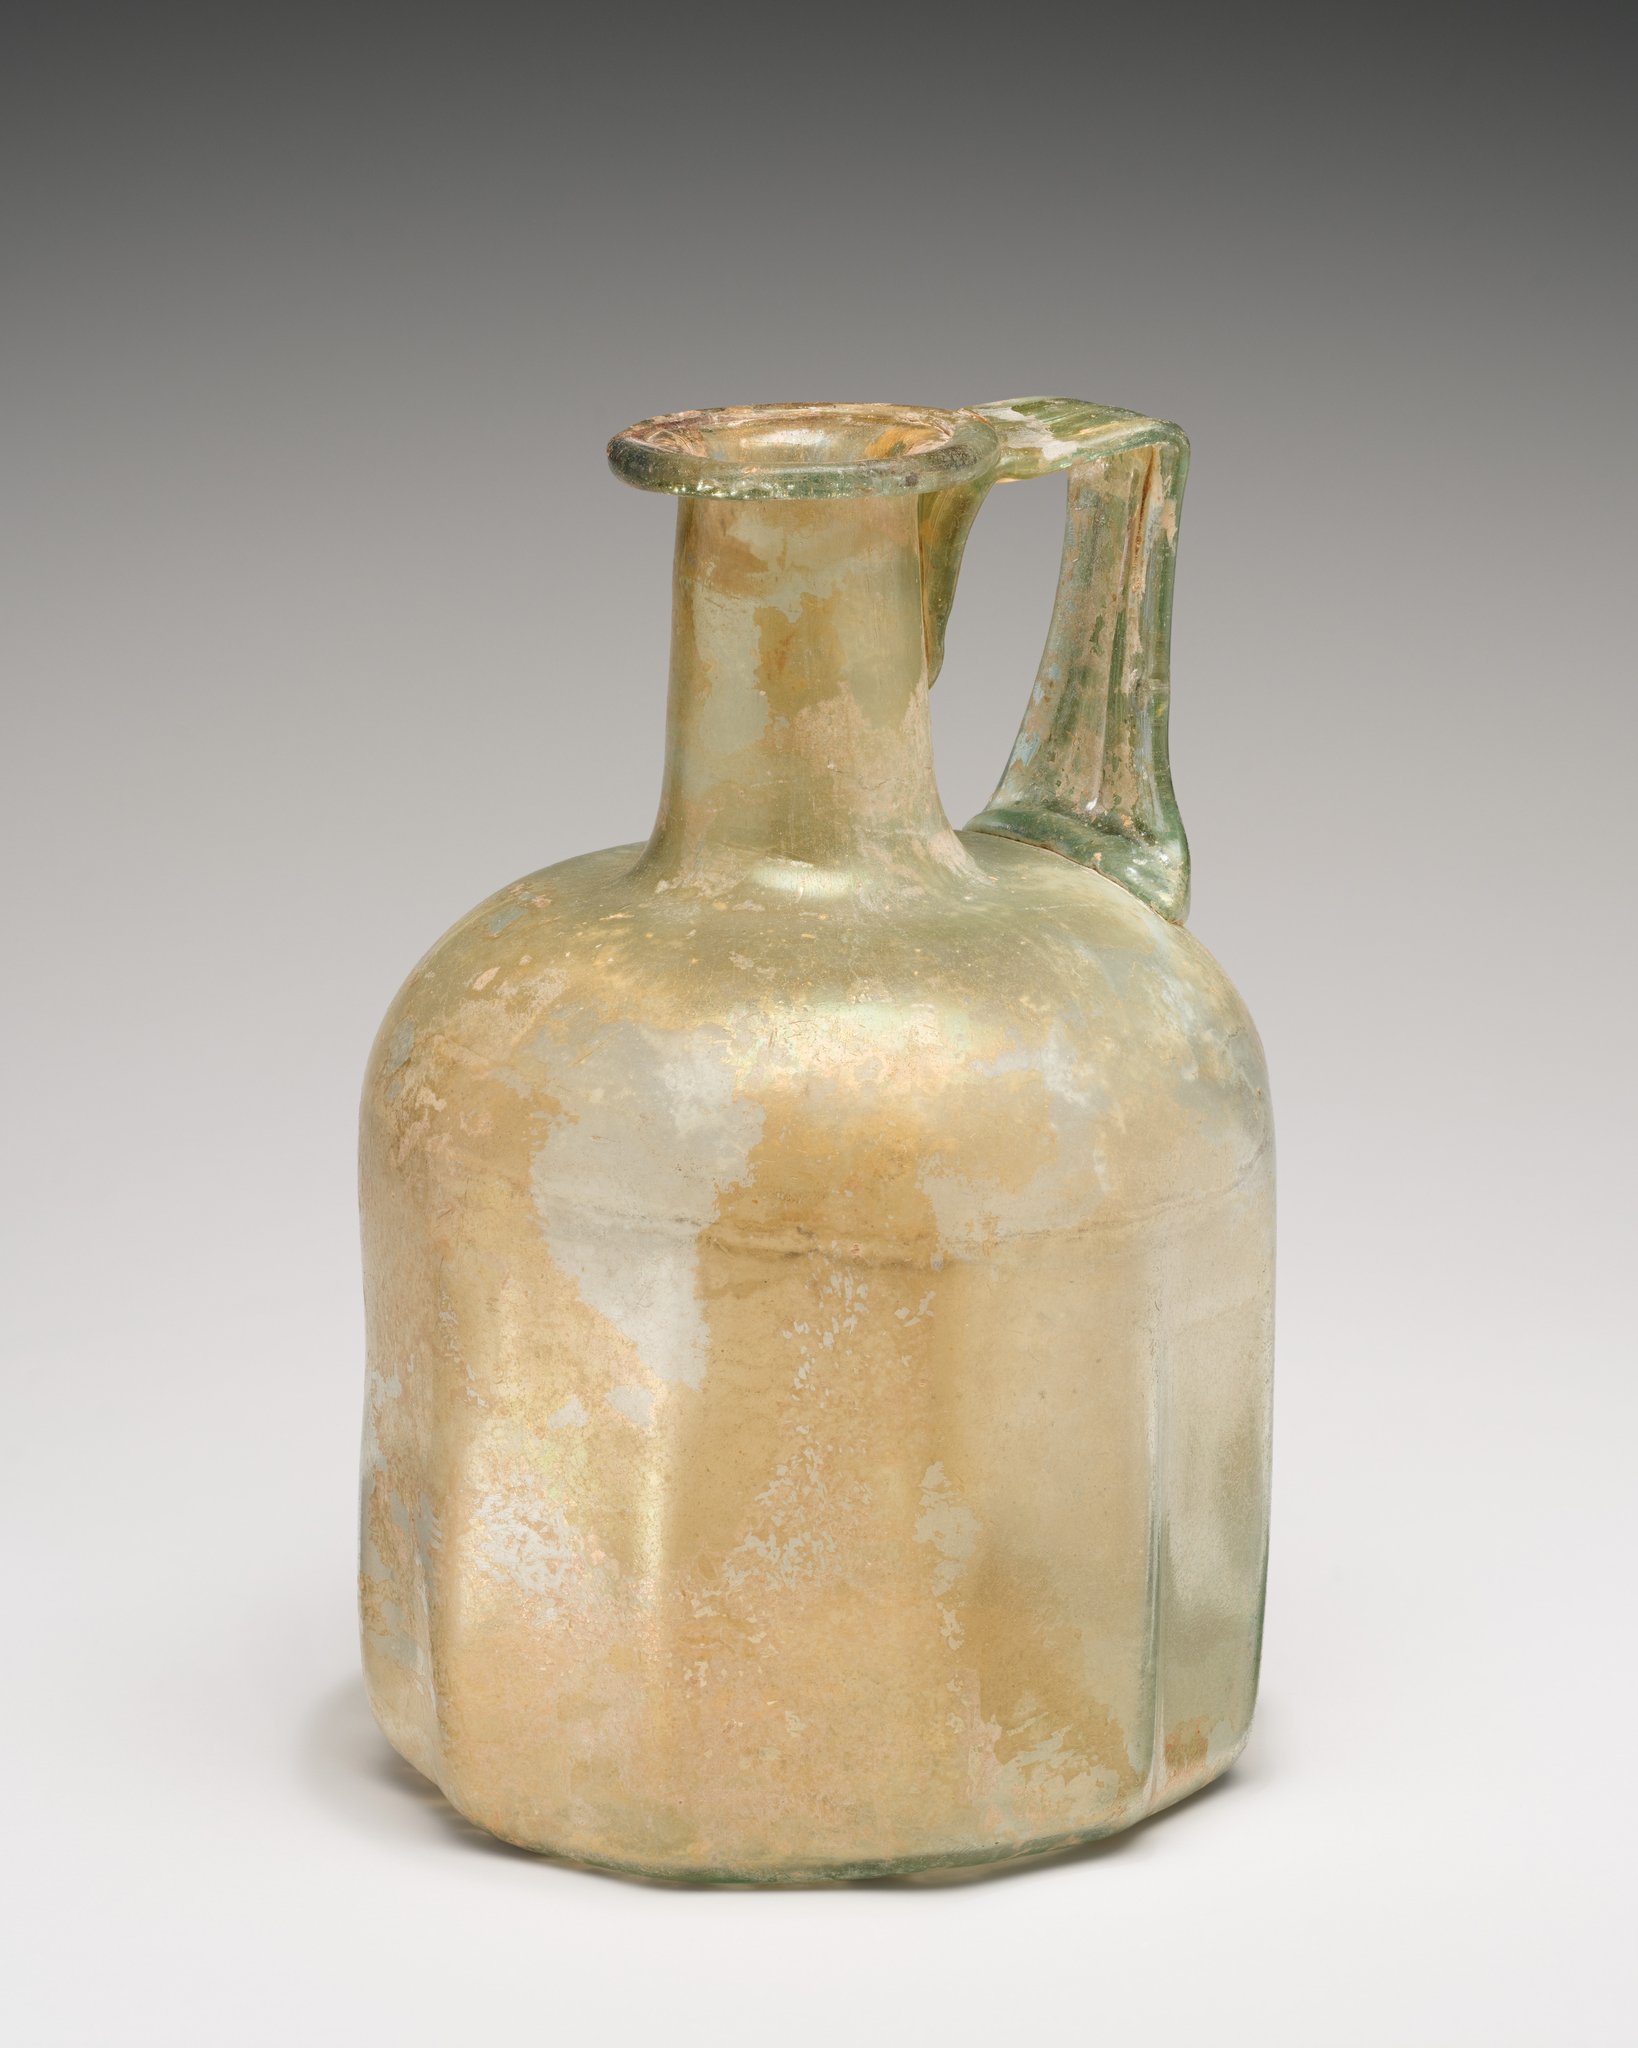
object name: bottle, polygonal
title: Glass polygonal bottle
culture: roman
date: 101-300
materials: glass